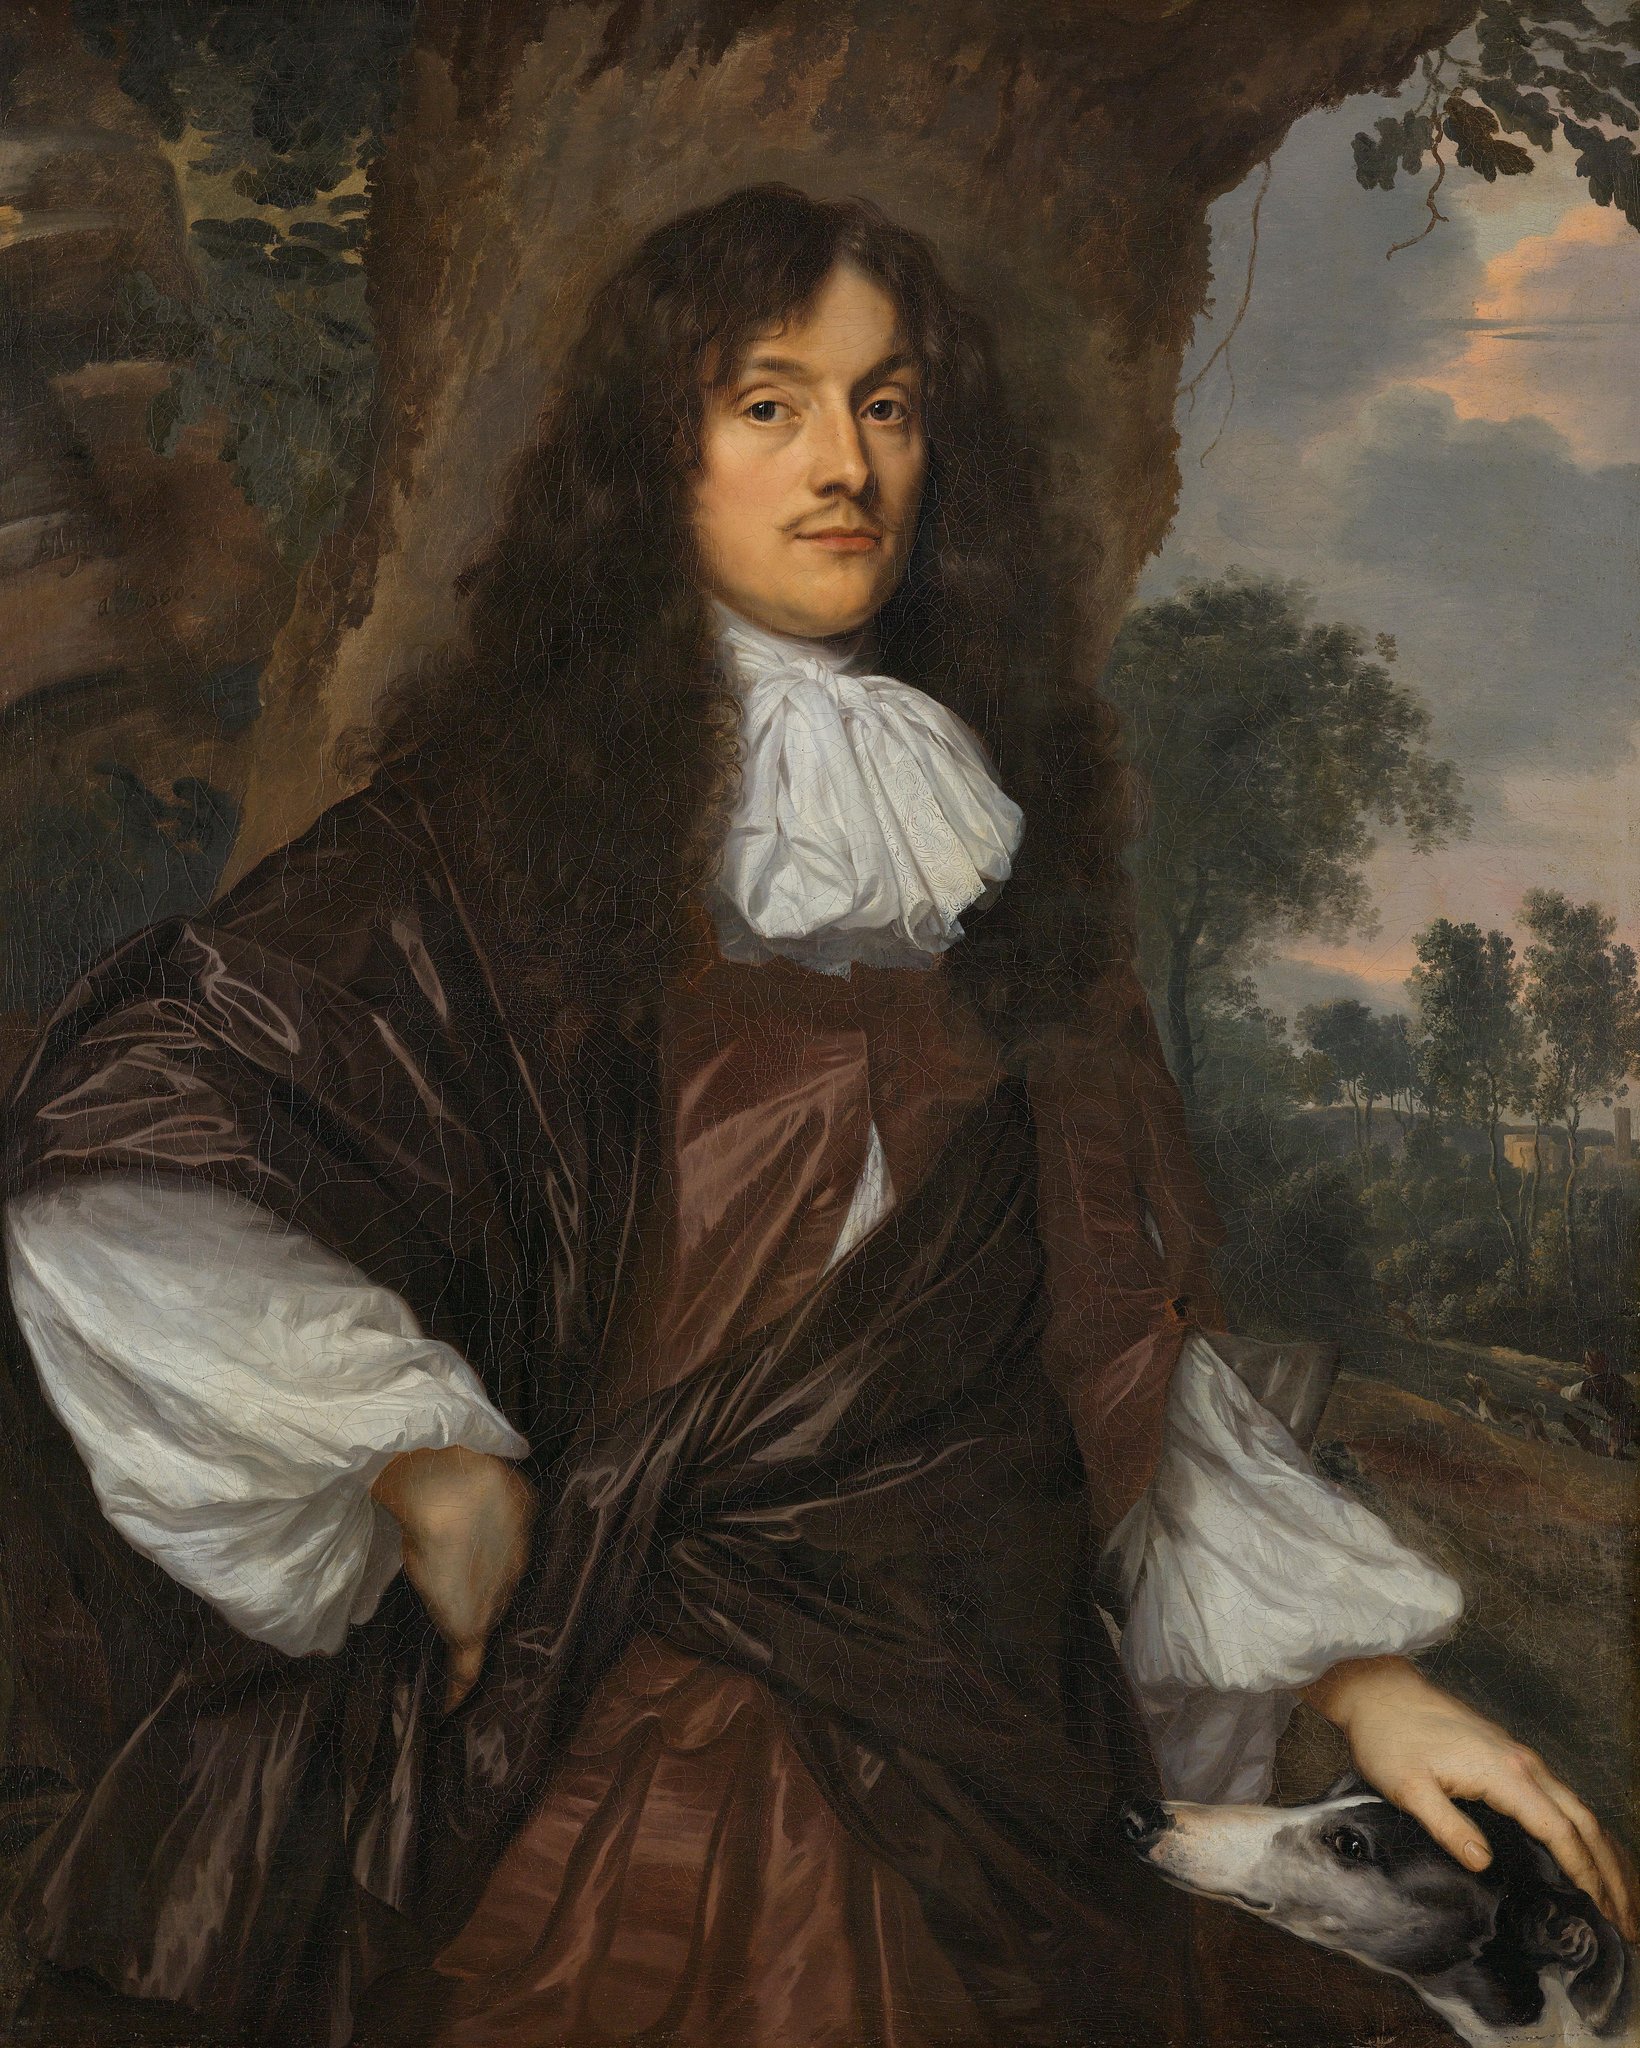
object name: painting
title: Portrait of Jacob de Witte (1628-79)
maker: jan mijtens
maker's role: painter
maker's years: 1614-1670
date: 1660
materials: canvas, oil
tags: historical persons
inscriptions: signature and date, upper left (j, A, N and M ligated): ‘jANMijtens. F: / a°: 1660.’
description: Jan Mijtens (1614 - 1670). Portrait of Jacob de Witte (1628 - 1679), Lord of Haamstede Signed and dated, 1660. In original gilt walnut frame.